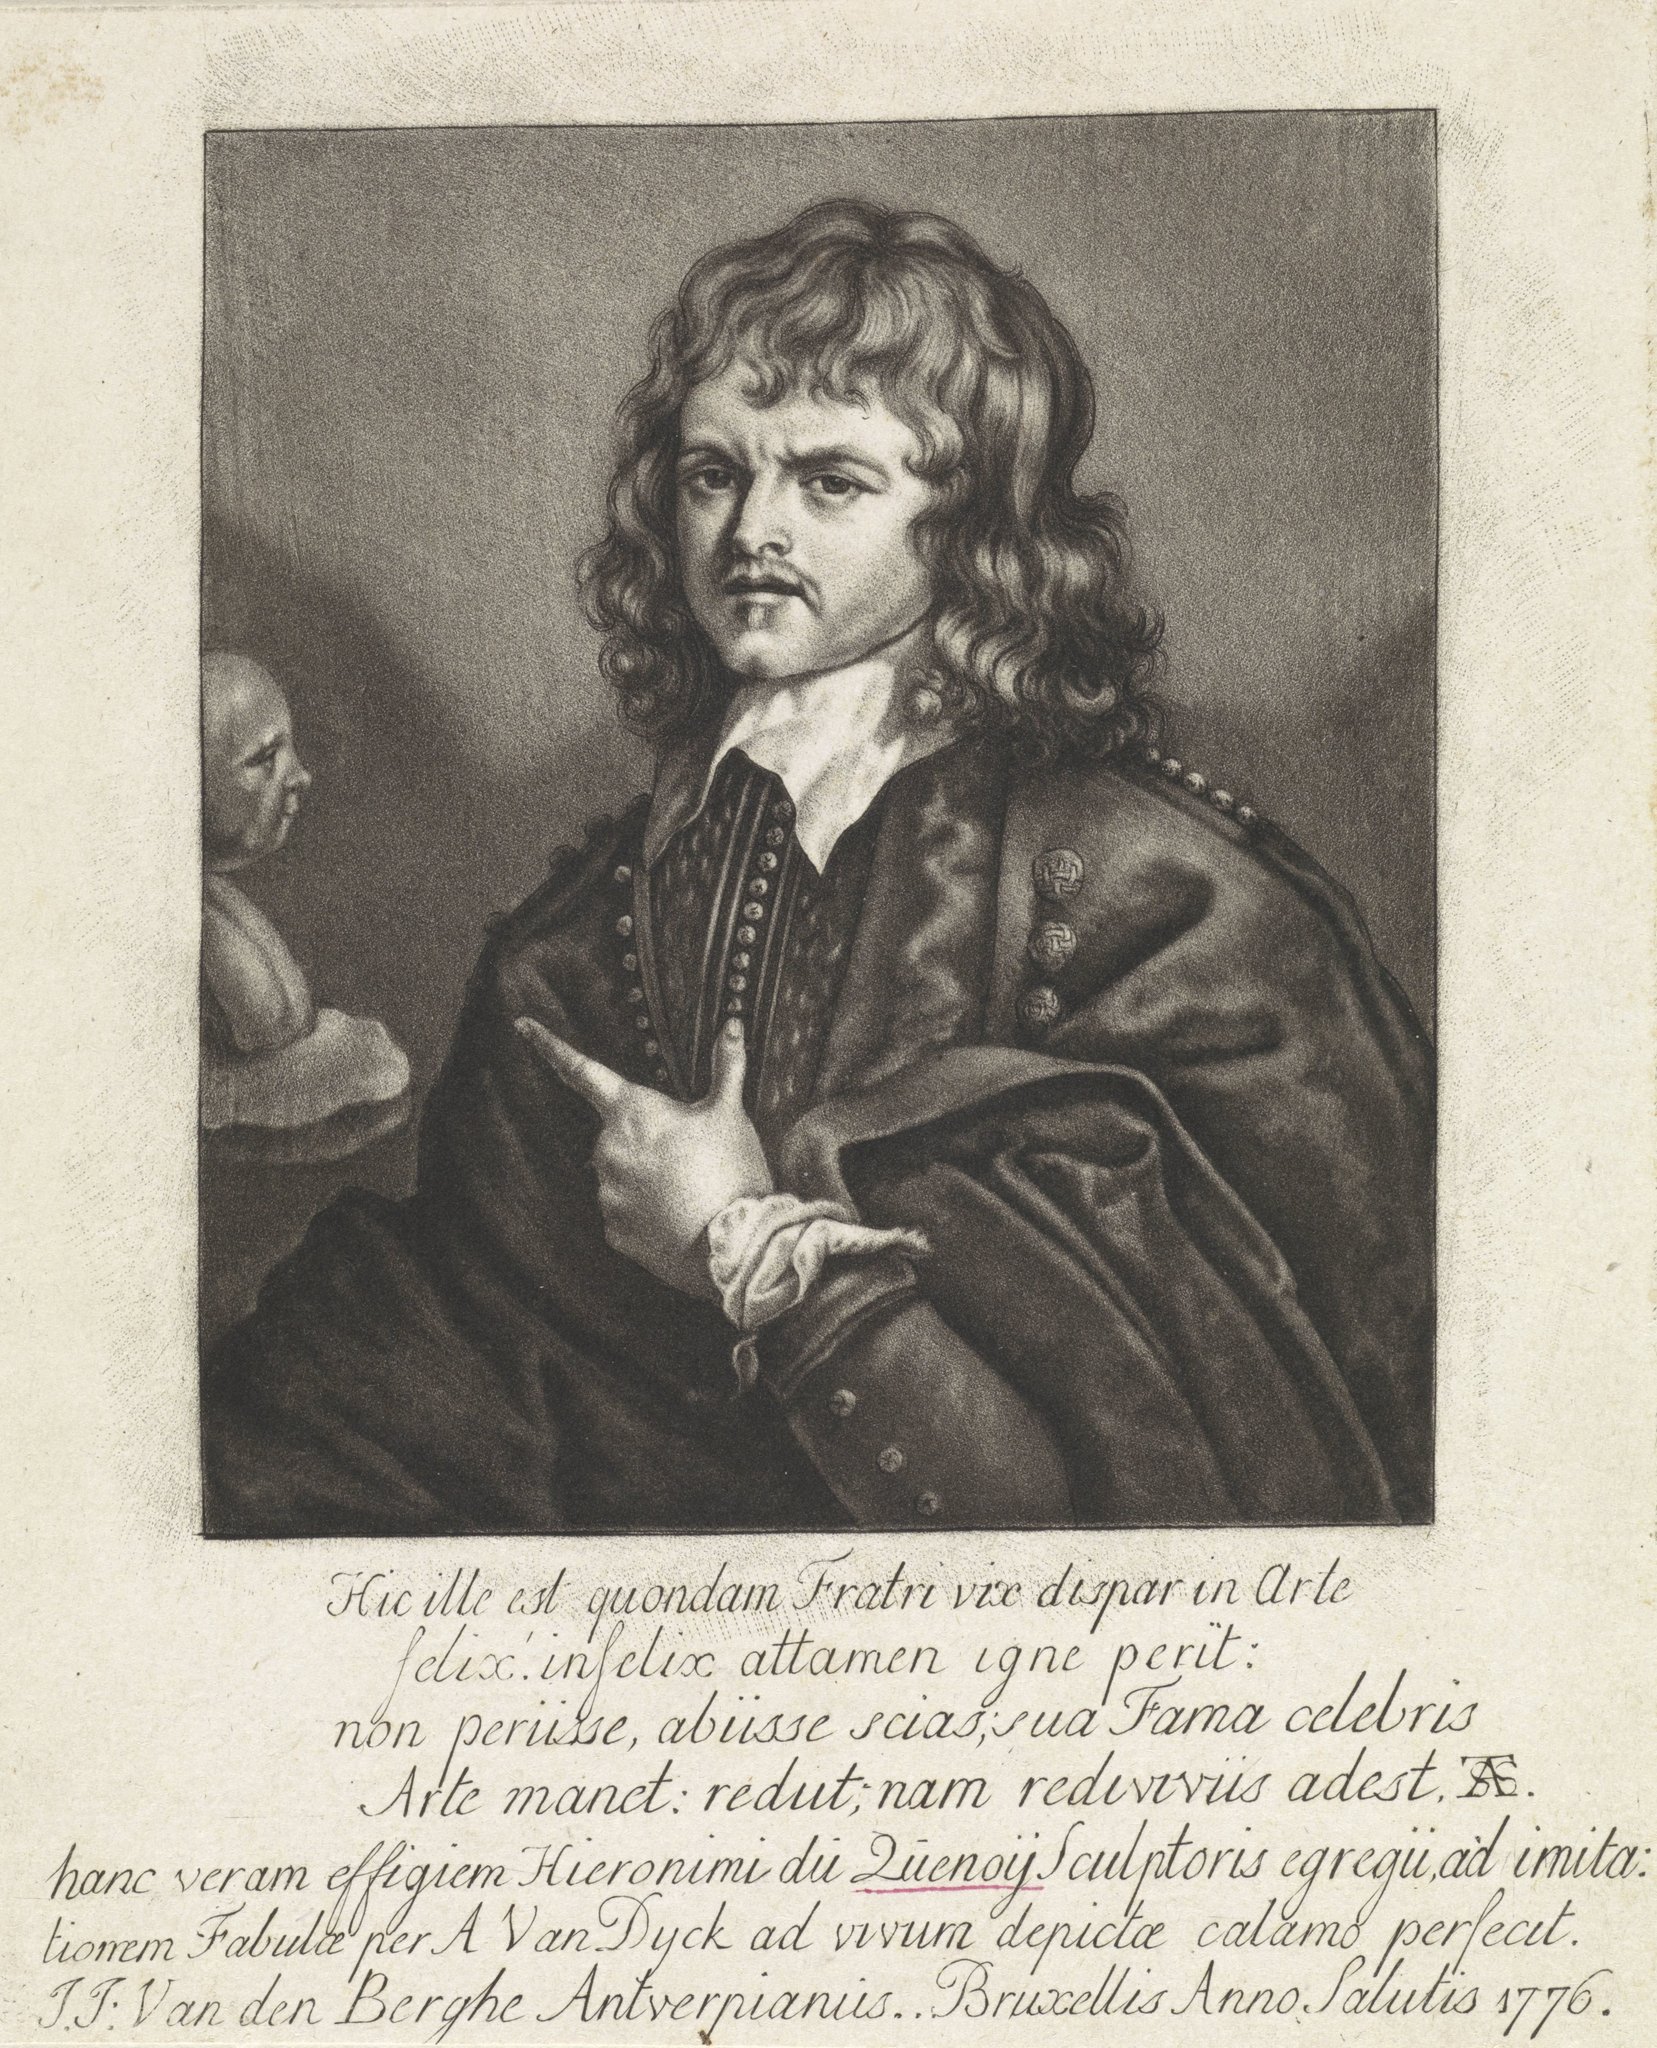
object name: print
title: Portret van de beeldhouwer Jerôme Duquesnoy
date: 1776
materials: paper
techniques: engraving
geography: brussels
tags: brussels, ghent, sculptor, jerôme duquesnoy (ii), portrait, self-portrait of sculptor, historical persons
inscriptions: collector's mark: Lugt 2612, collector's mark: Lugt 2228